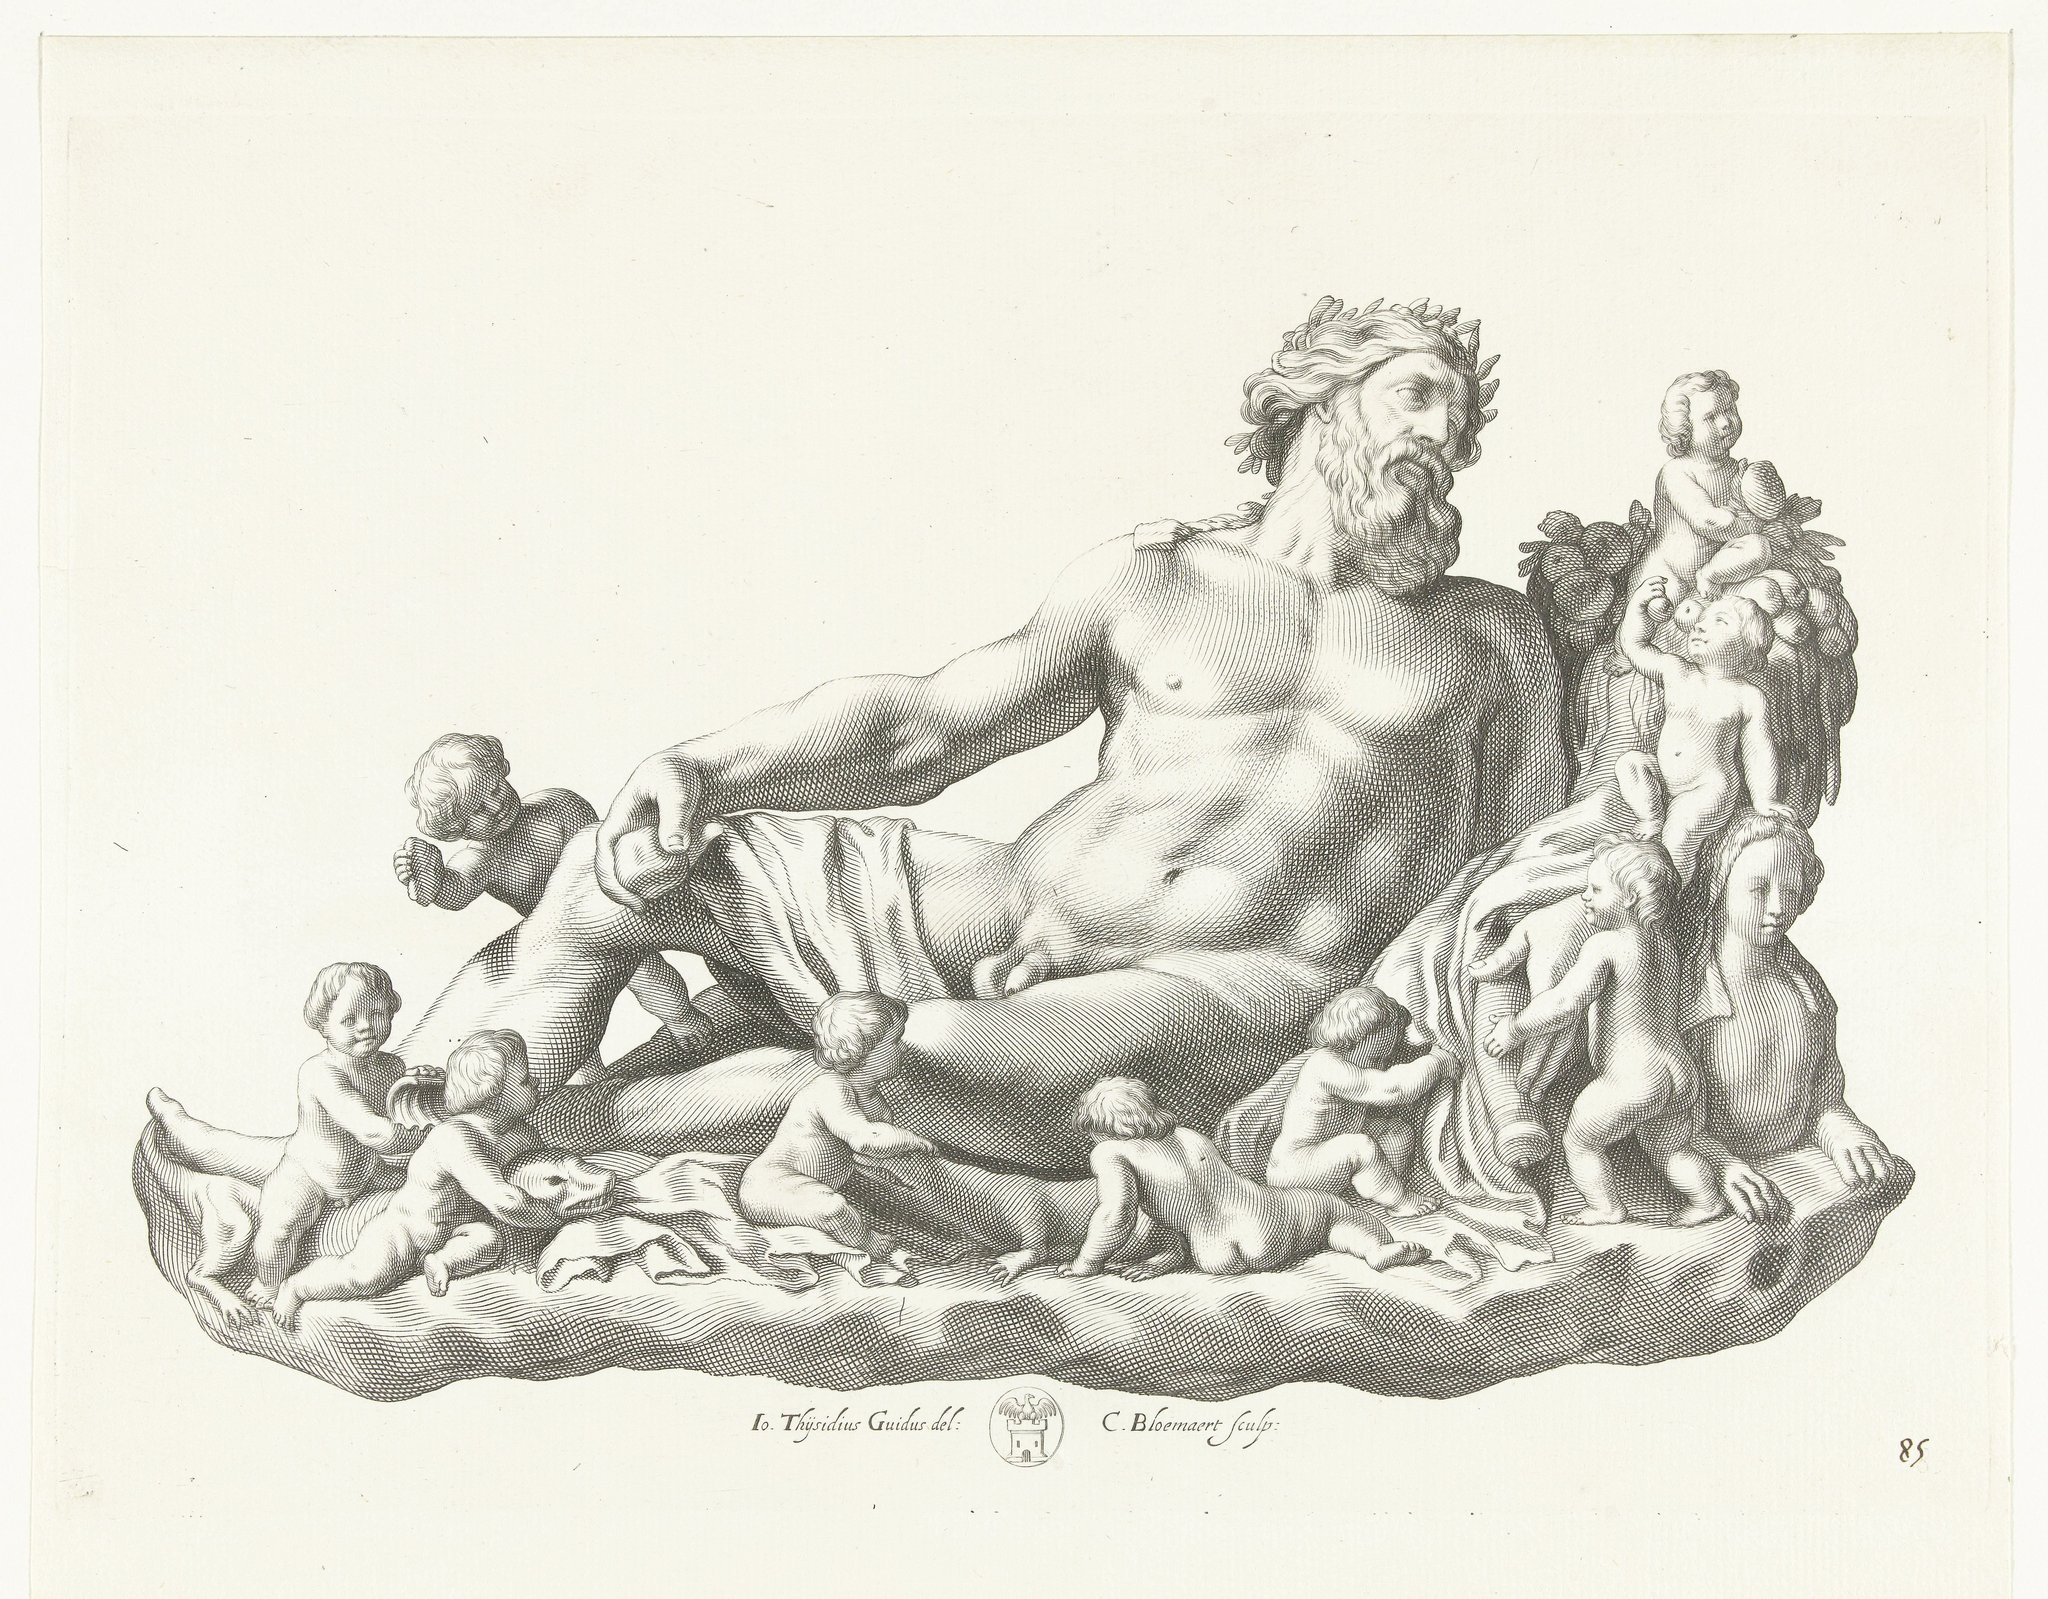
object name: print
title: Riviergod van de Nijl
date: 1636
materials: paper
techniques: engraving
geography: rome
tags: piece of sculpture, reproduction of a piece of sculpture, personification of river nile; 'nilo' (ripa)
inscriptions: number: ‘85’, collector's mark: Lugt 2228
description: Beeld van een naakte liggende man die op een hoorn des overvloeds leunt. Om hem heen spelen putti. Het beeld is afkomstig uit de collectie van Vincenzo Giustiniani, wiens wapen onder de sokkel te zien is.